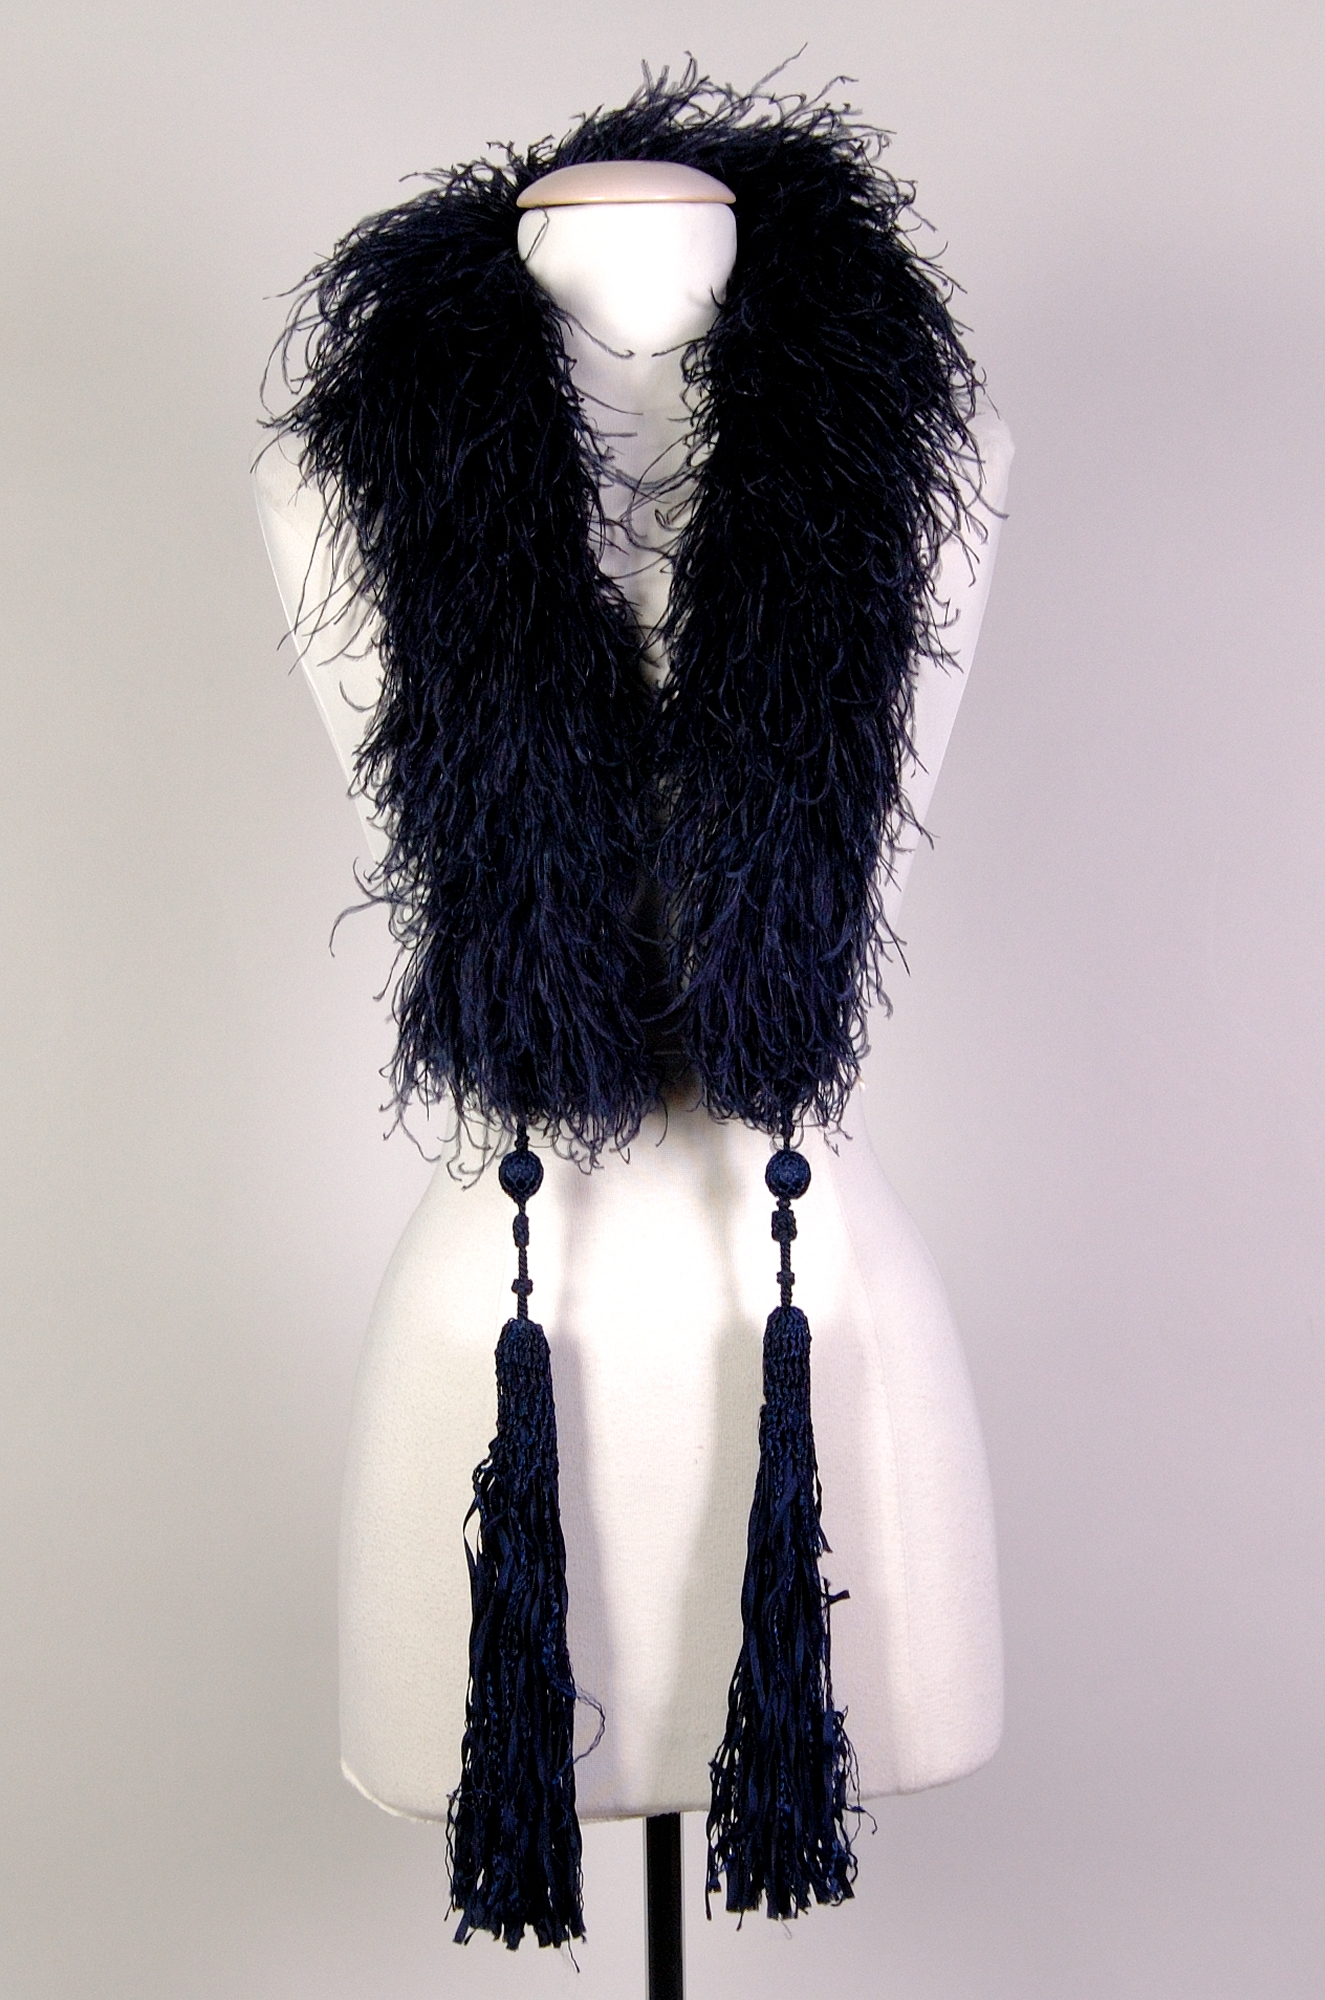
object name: boa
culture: french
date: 1895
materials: feather, silk